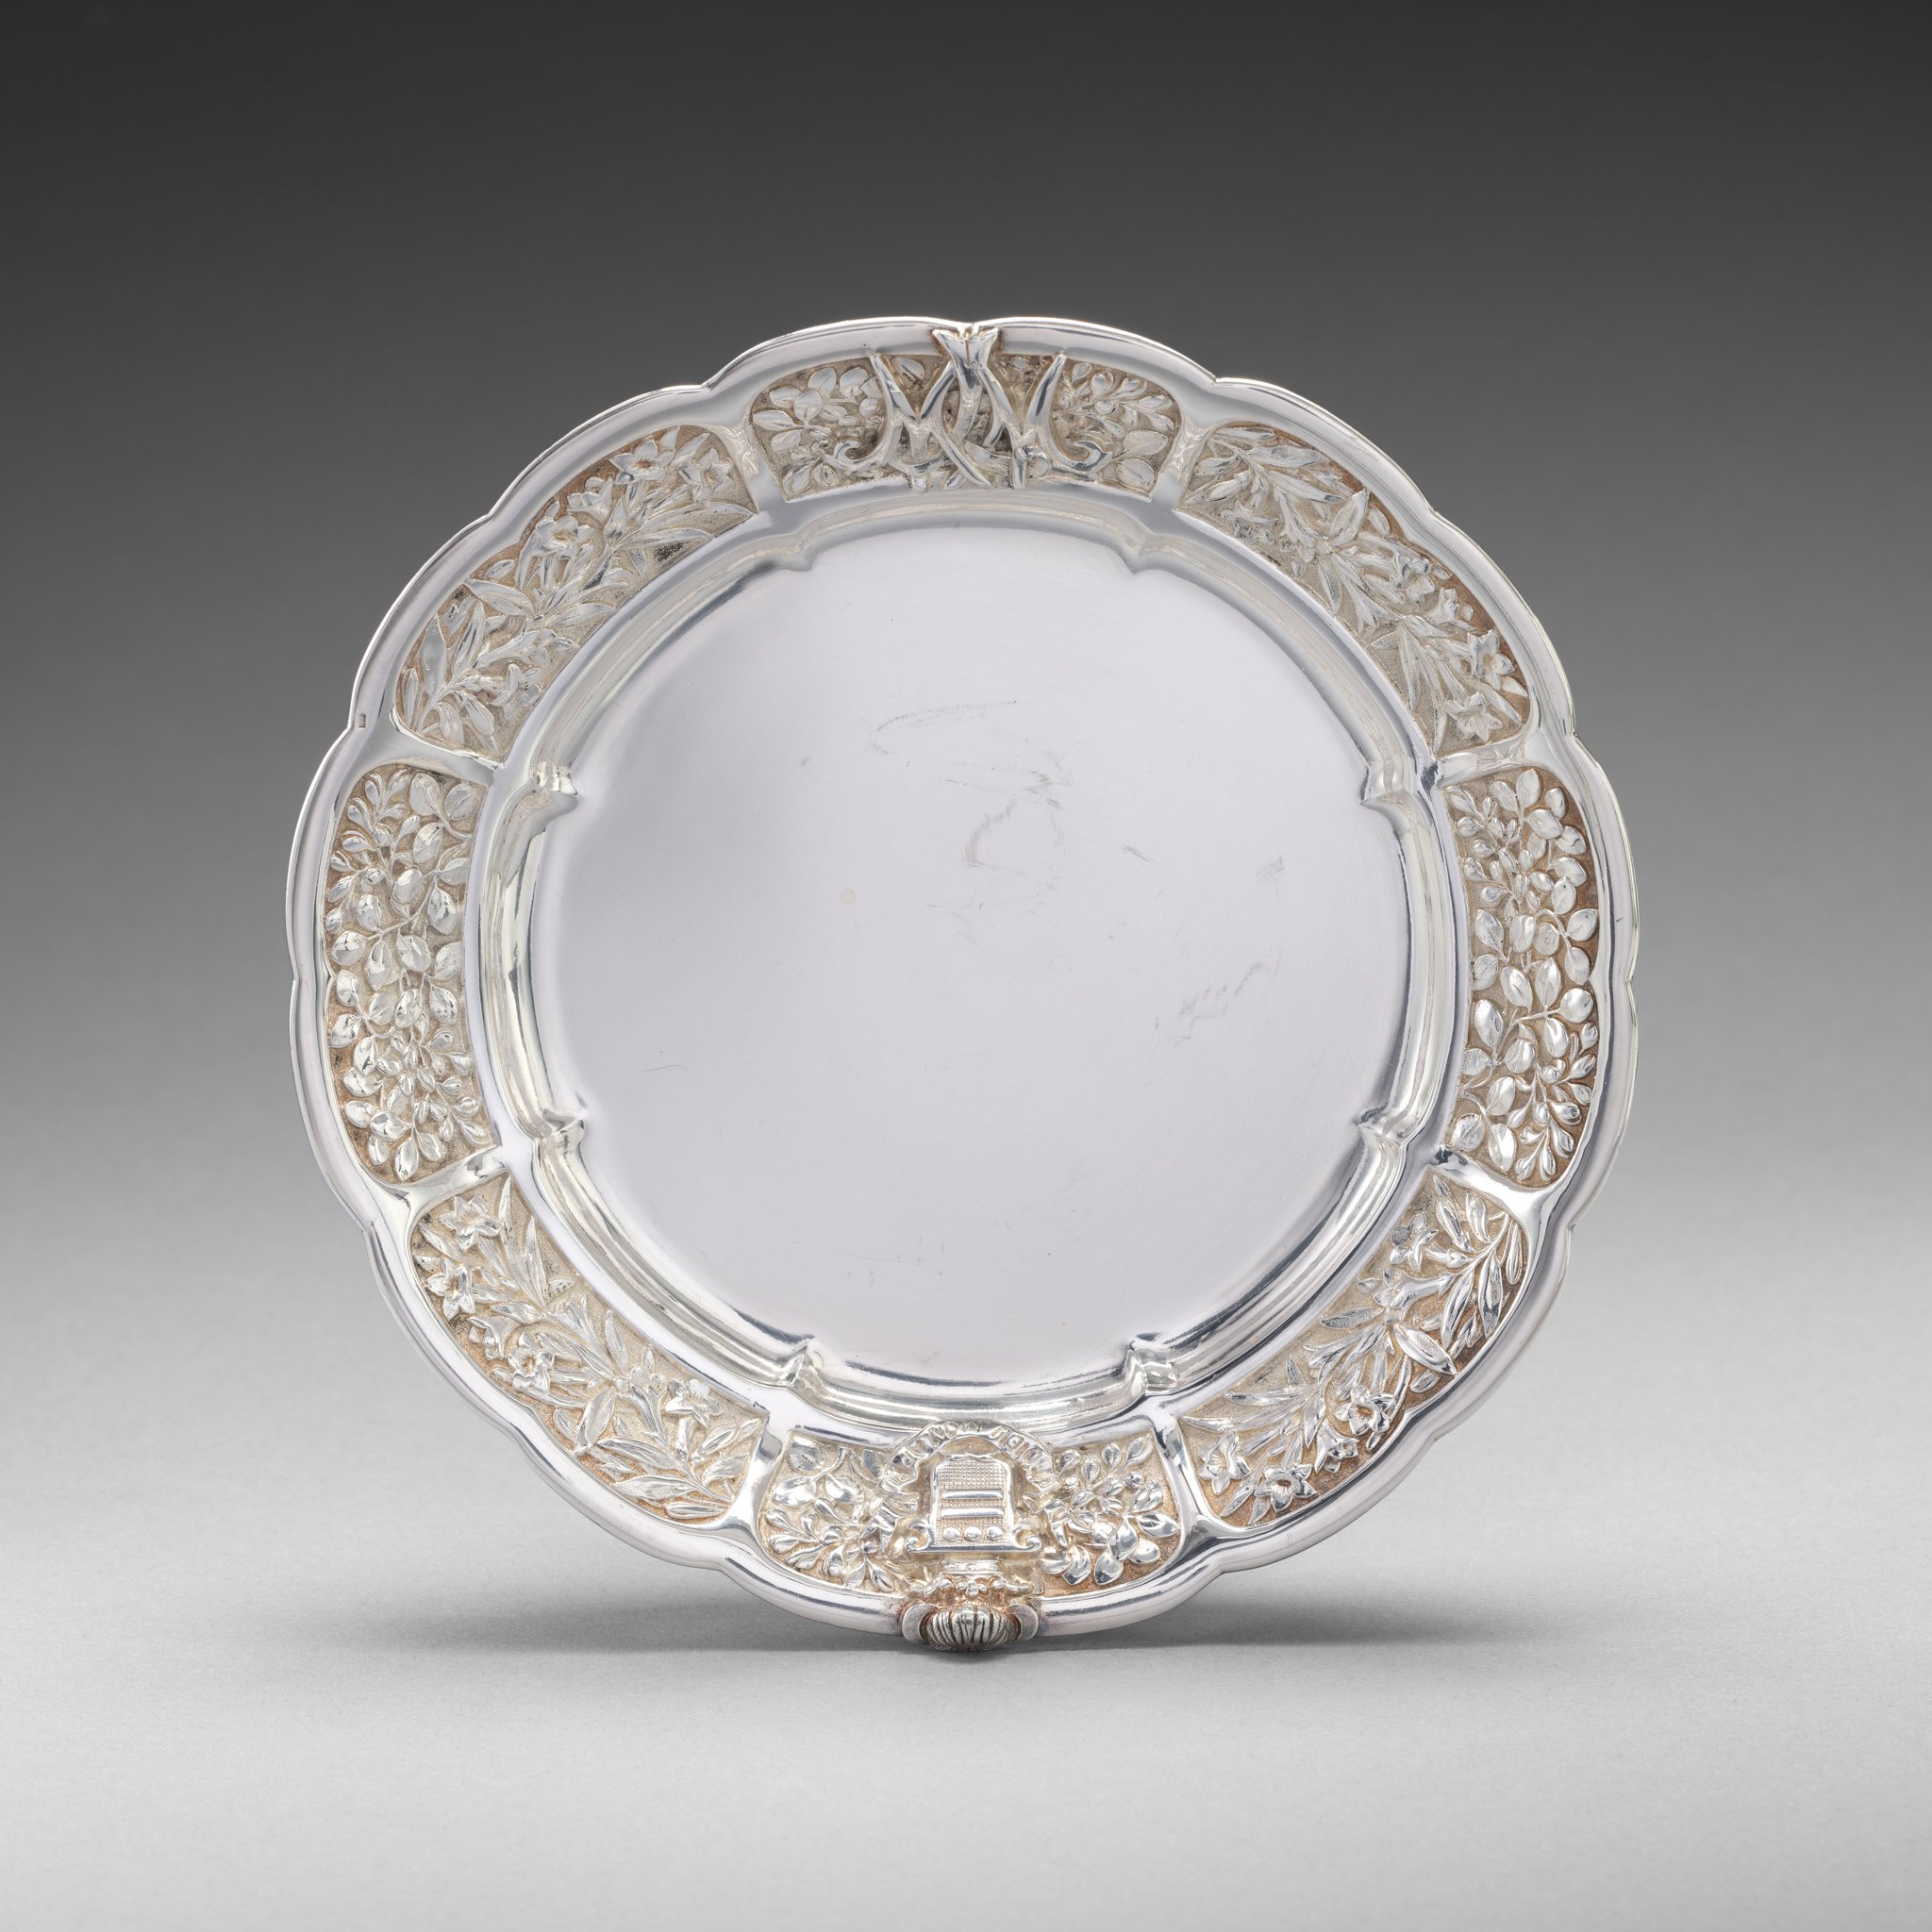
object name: ice cream plate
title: Ice Cream Plate from Mackay Service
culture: american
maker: tiffany & co.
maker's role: maker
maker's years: 1837-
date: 1878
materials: silver